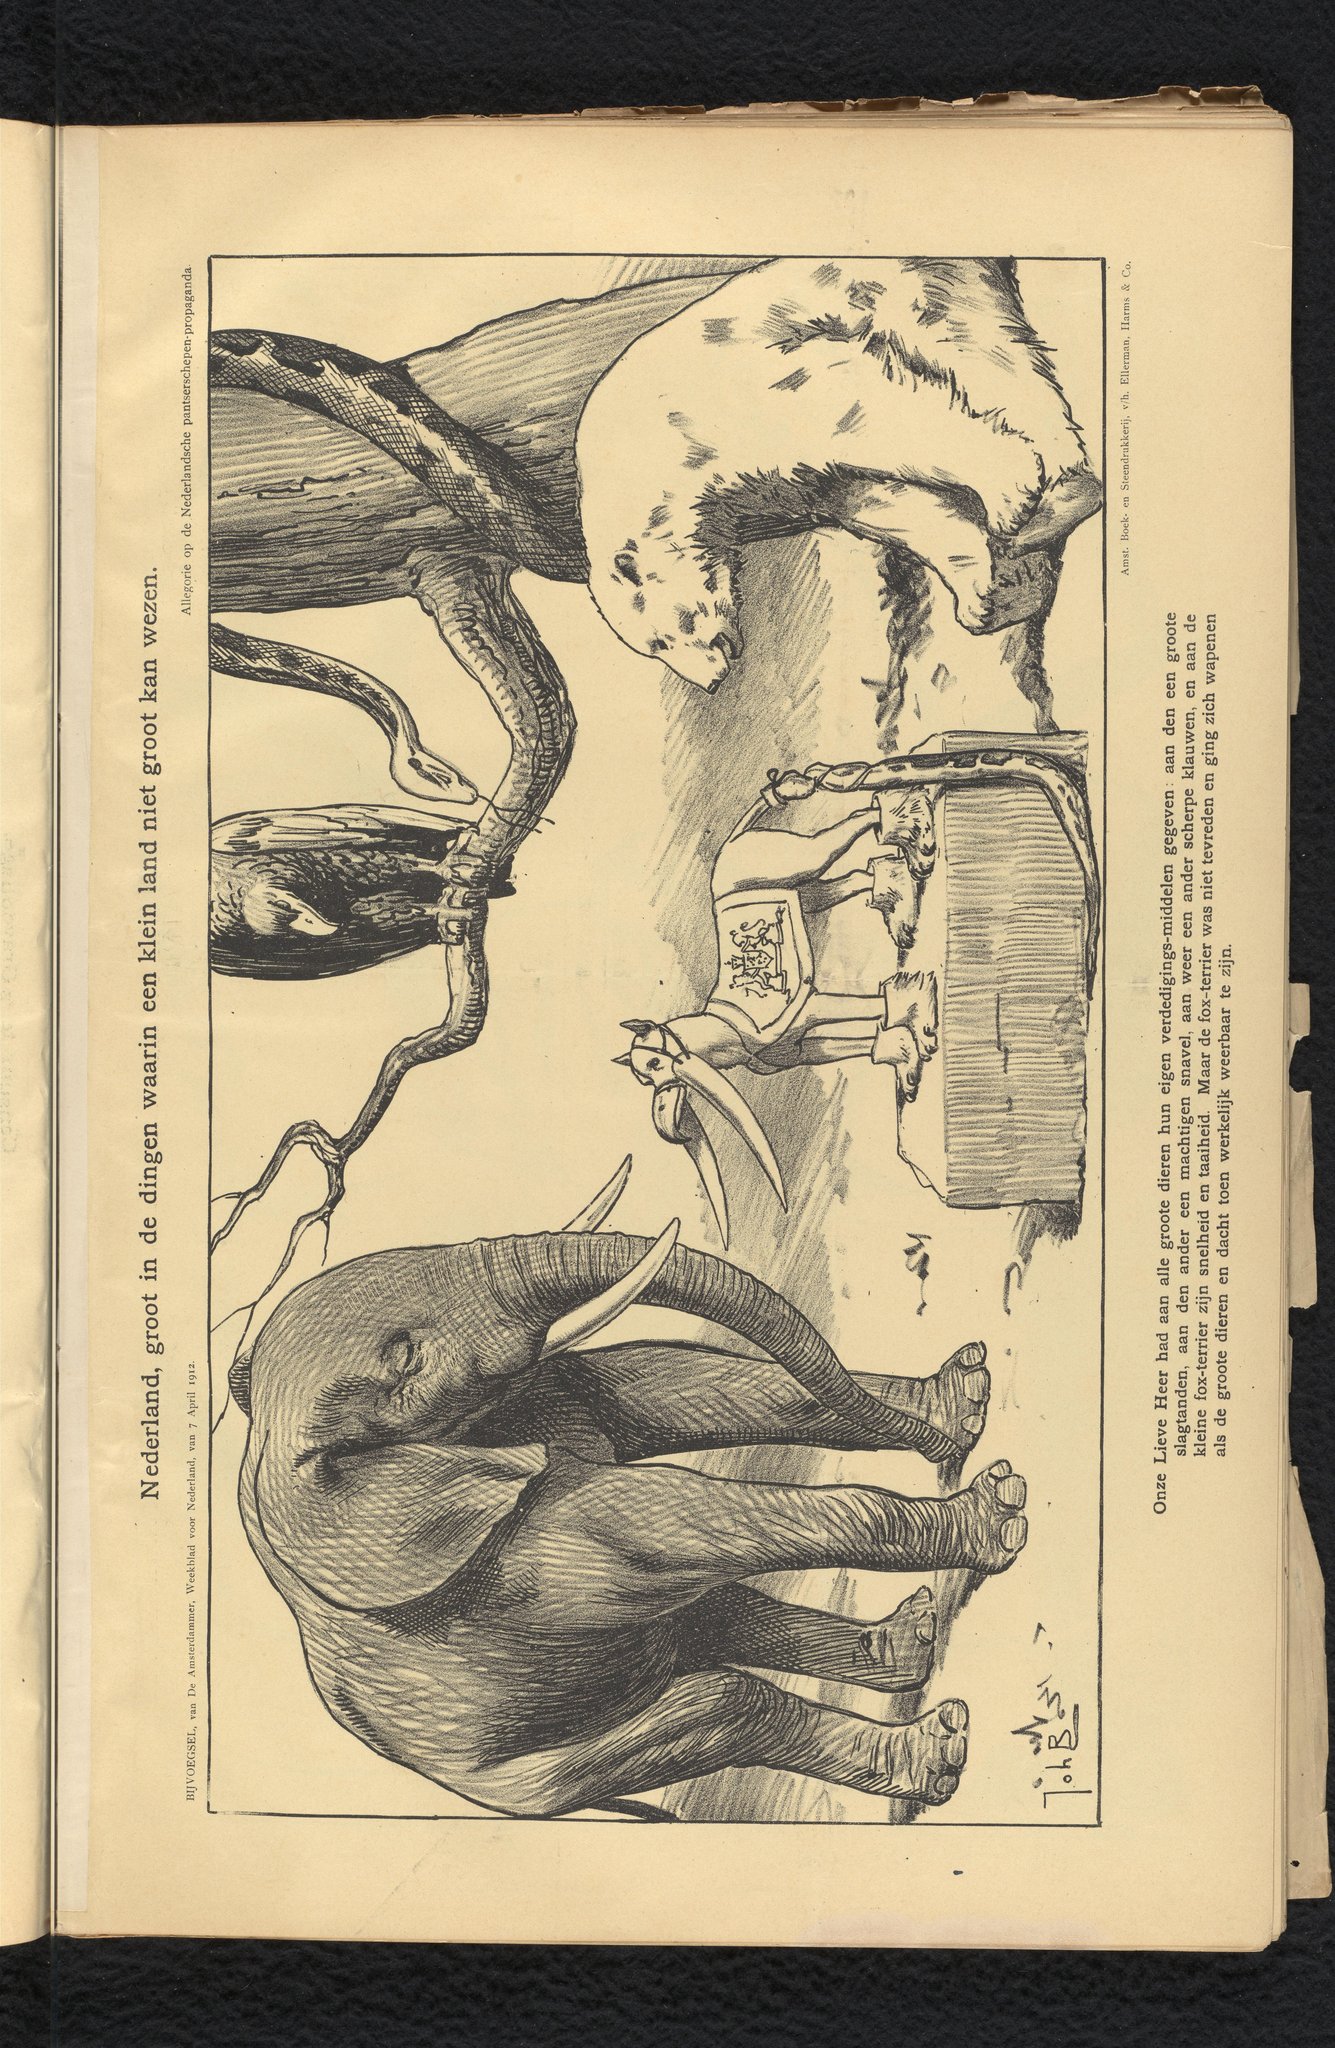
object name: cartoon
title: Nederland, groot in de dingen waarin een klein land niet groot kan wezen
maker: johan braakensiek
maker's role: draughtsman, print maker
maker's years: 1858-1940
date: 1912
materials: paper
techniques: lithograph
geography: amsterdam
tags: beasts of prey, predatory animals: polar bear, snakes, predatory birds: eagle, personifications of countries, nations, states, districts, etc., trunked animals: elephant, political caricatures and satires, dog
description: Nederland als een kleine hond (foxterriër) die zich uit ontevredenheid gaat wapenen met de wapens van andere grote (roof)dieren. Parabel op de Nederlandse behoefte aan pantserschepen.